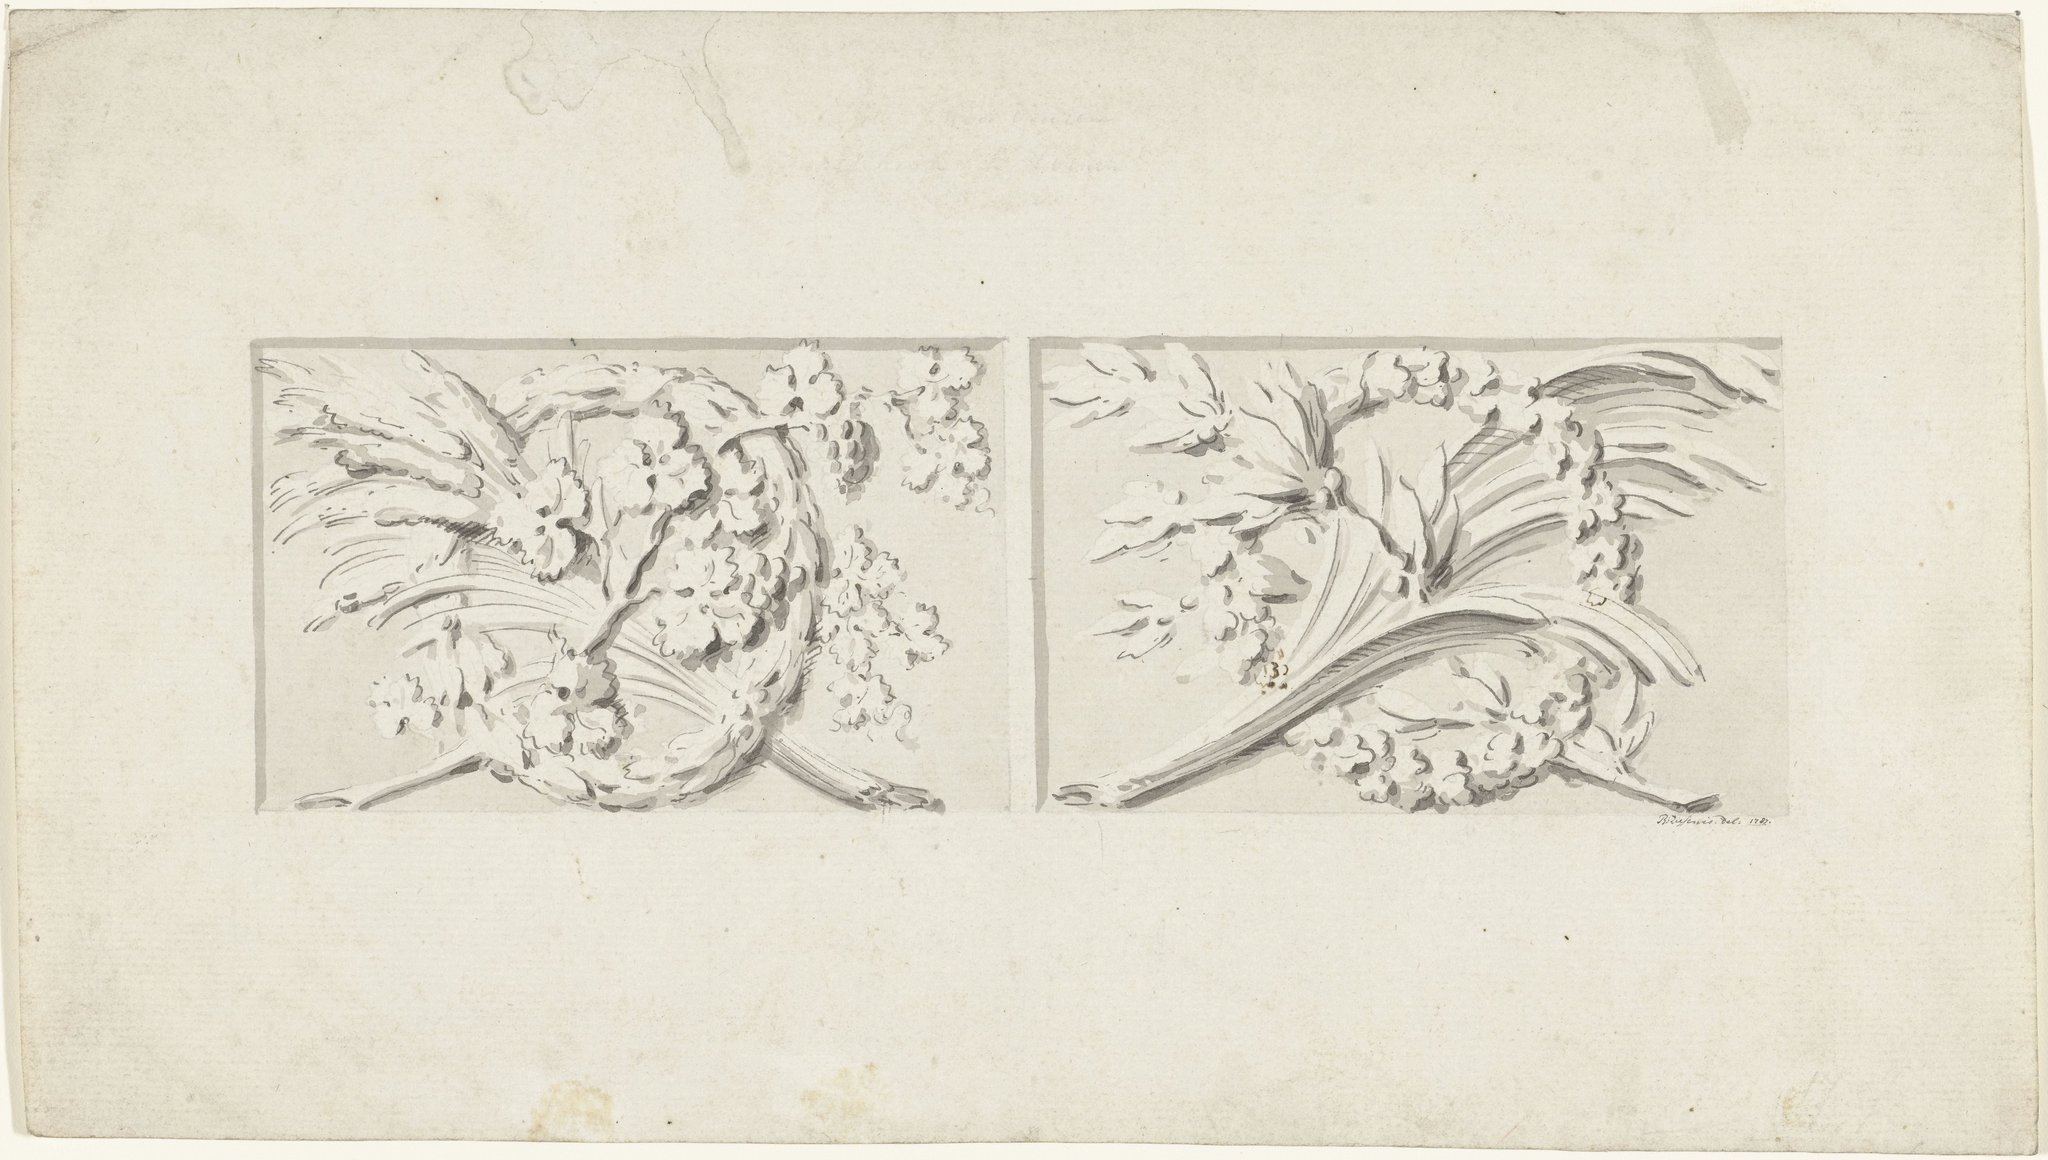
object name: design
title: Ontwerp voor twee decoraties in rechthoekige verdiepte vlakken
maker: bartholomeus ziesenis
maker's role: draughtsman, sculptor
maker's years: 1768-1820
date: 1787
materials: ink, paper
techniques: brush, pen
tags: ornament derived from plant forms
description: Ontwerp voor twee decoraties in rechthoekige verdiepte vlakken, voor stucco of snijwerk.